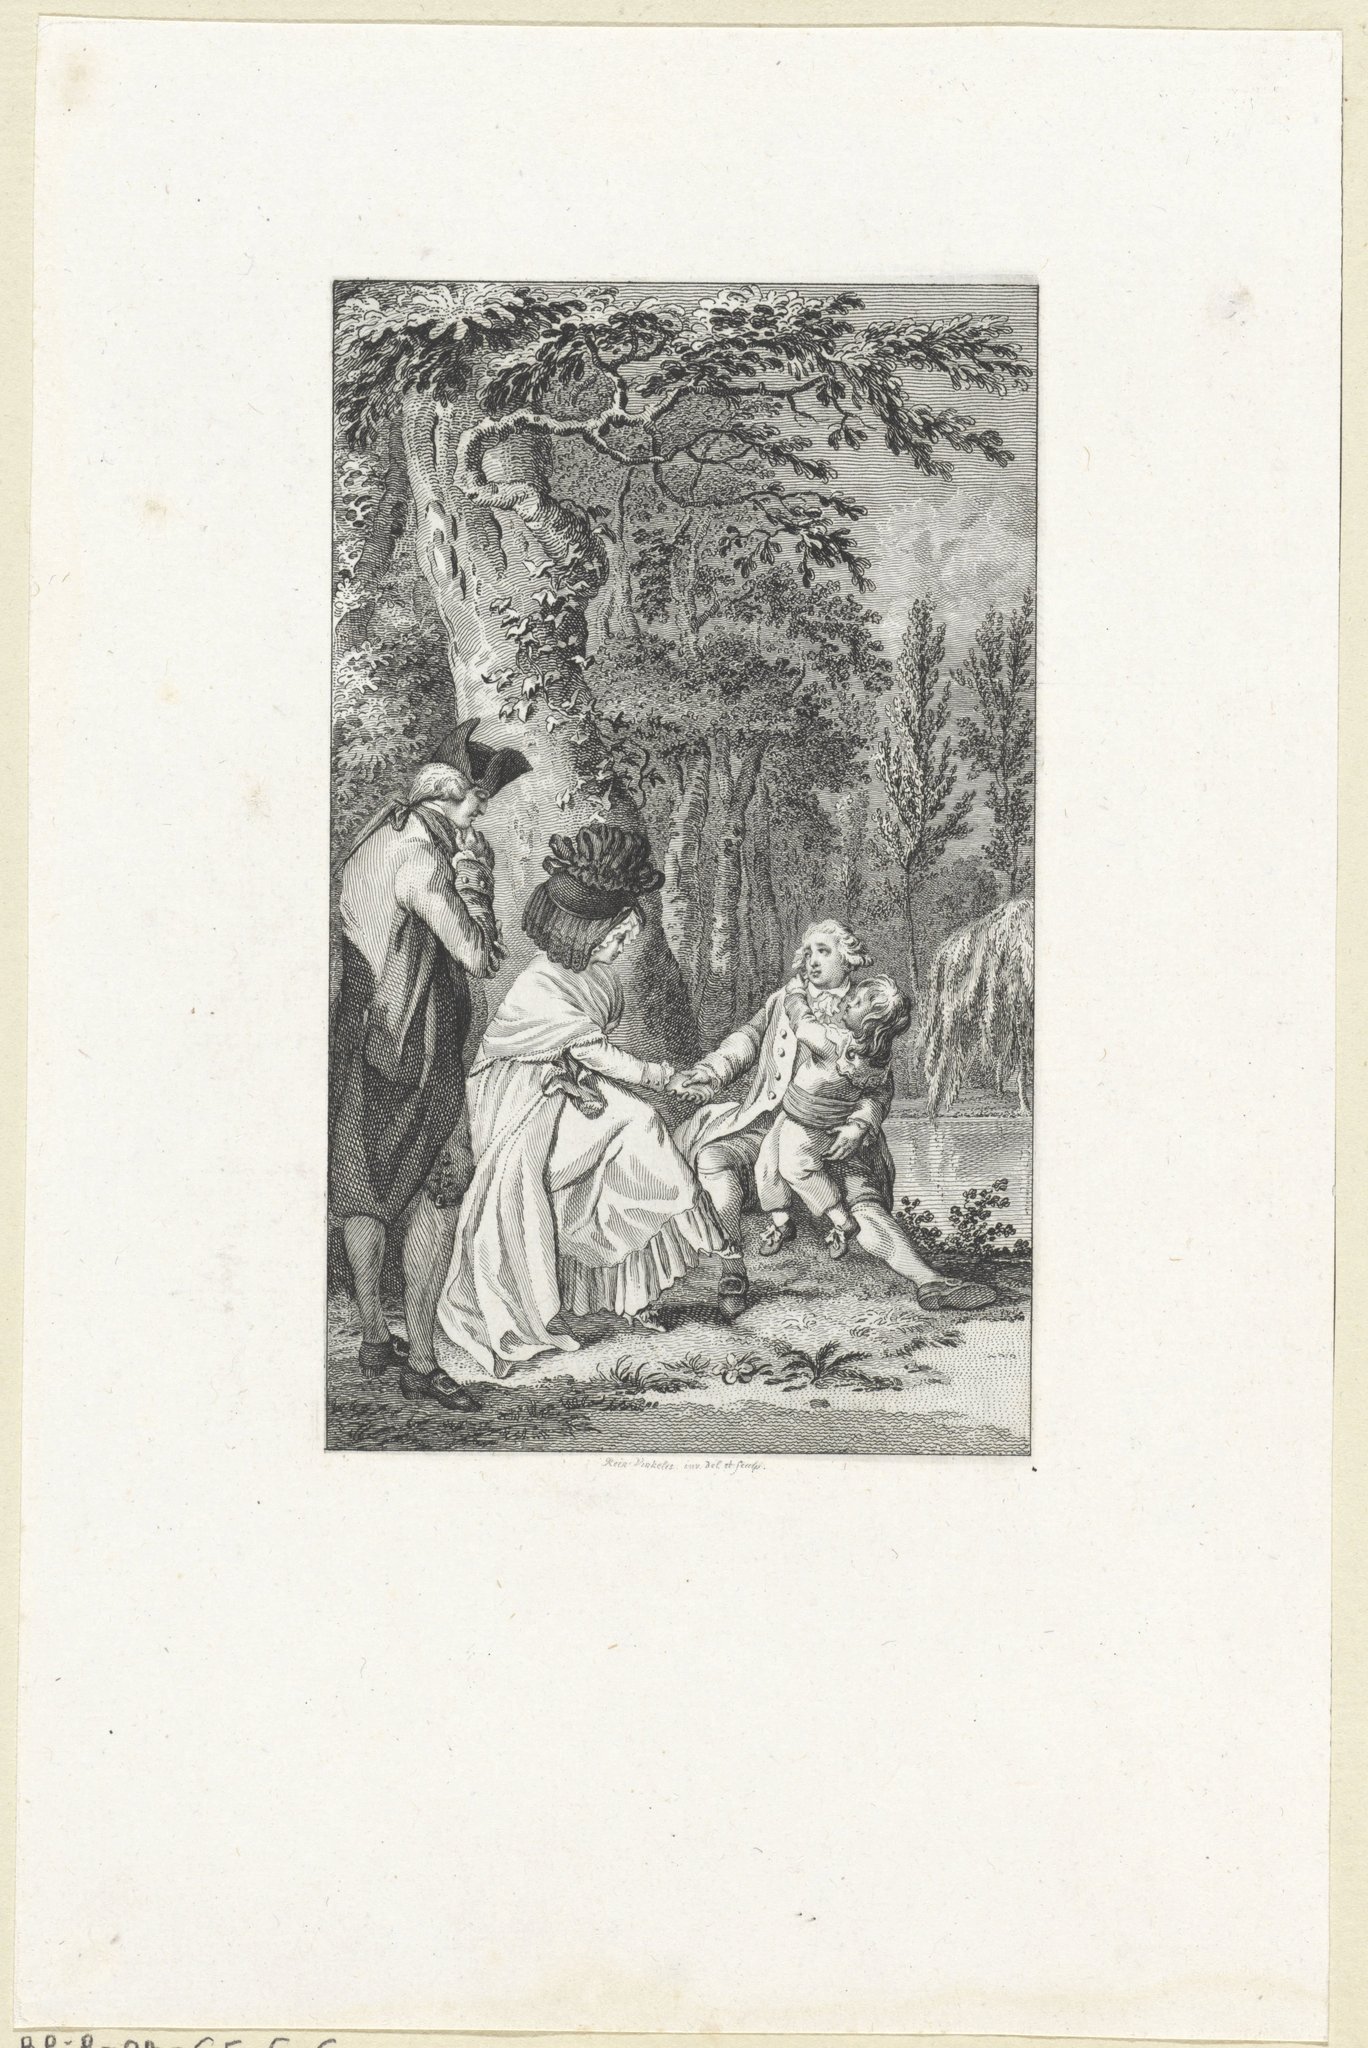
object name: print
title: Bij een bosvijver geven een man en een vrouw elkaar een hand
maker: reinier vinkeles (i)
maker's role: draughtsman, print maker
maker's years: 1741-1816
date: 1751-1816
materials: paper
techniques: engraving, etching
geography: amsterdam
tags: shaking hands, 'dextrarum junctio', forest, wood, pond, pool, father and son(s) (family group)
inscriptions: inscription: ‘"Ook ik gevoel onze scheiding." zij drukte mij de hand, / I.D.Bladz. 22.’, collector's mark: Lugt 240